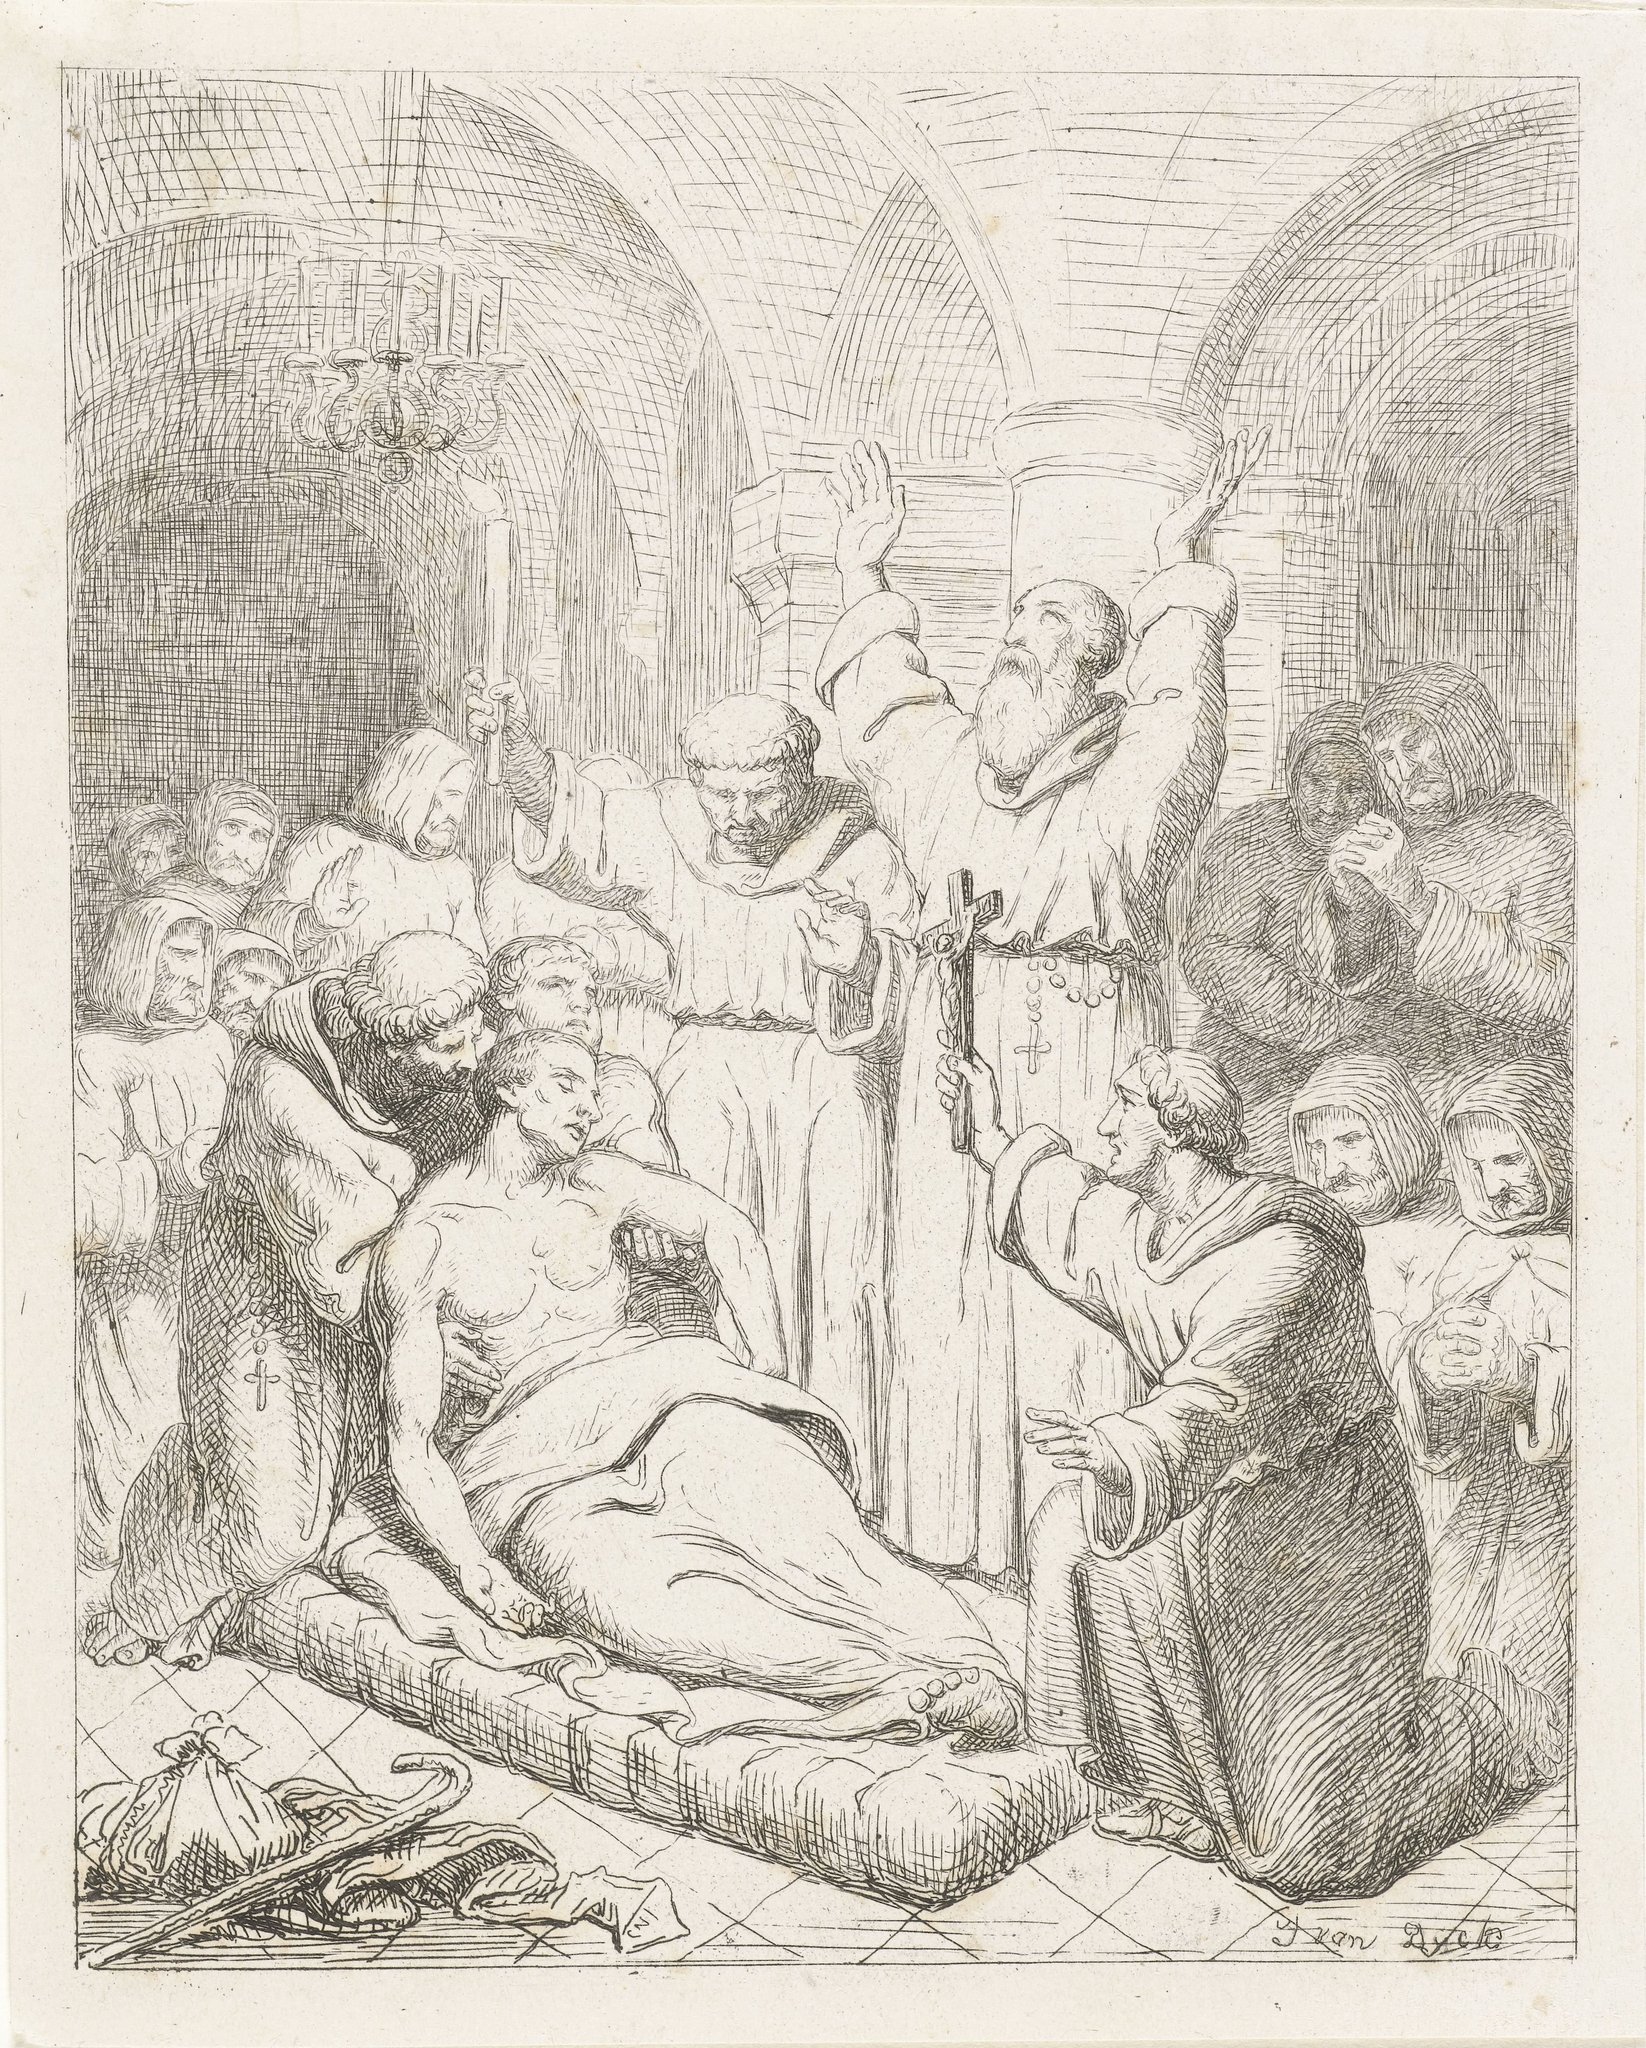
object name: book illustration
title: De dood van Tiddo Winnenga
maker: jacobus van dijck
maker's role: print maker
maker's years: 1817-1896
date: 1853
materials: paper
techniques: etching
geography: netherlands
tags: deathbed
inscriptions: collector's mark: Lugt 2228, collector's mark: Lugt 2760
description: Tiddo Winnenga sterft in het klooster Palmaar in begeleiding van de kloosterlingen en de abt. Illustratie voor het verhaal Tiddo Winnengha van J.J. van der Horst.